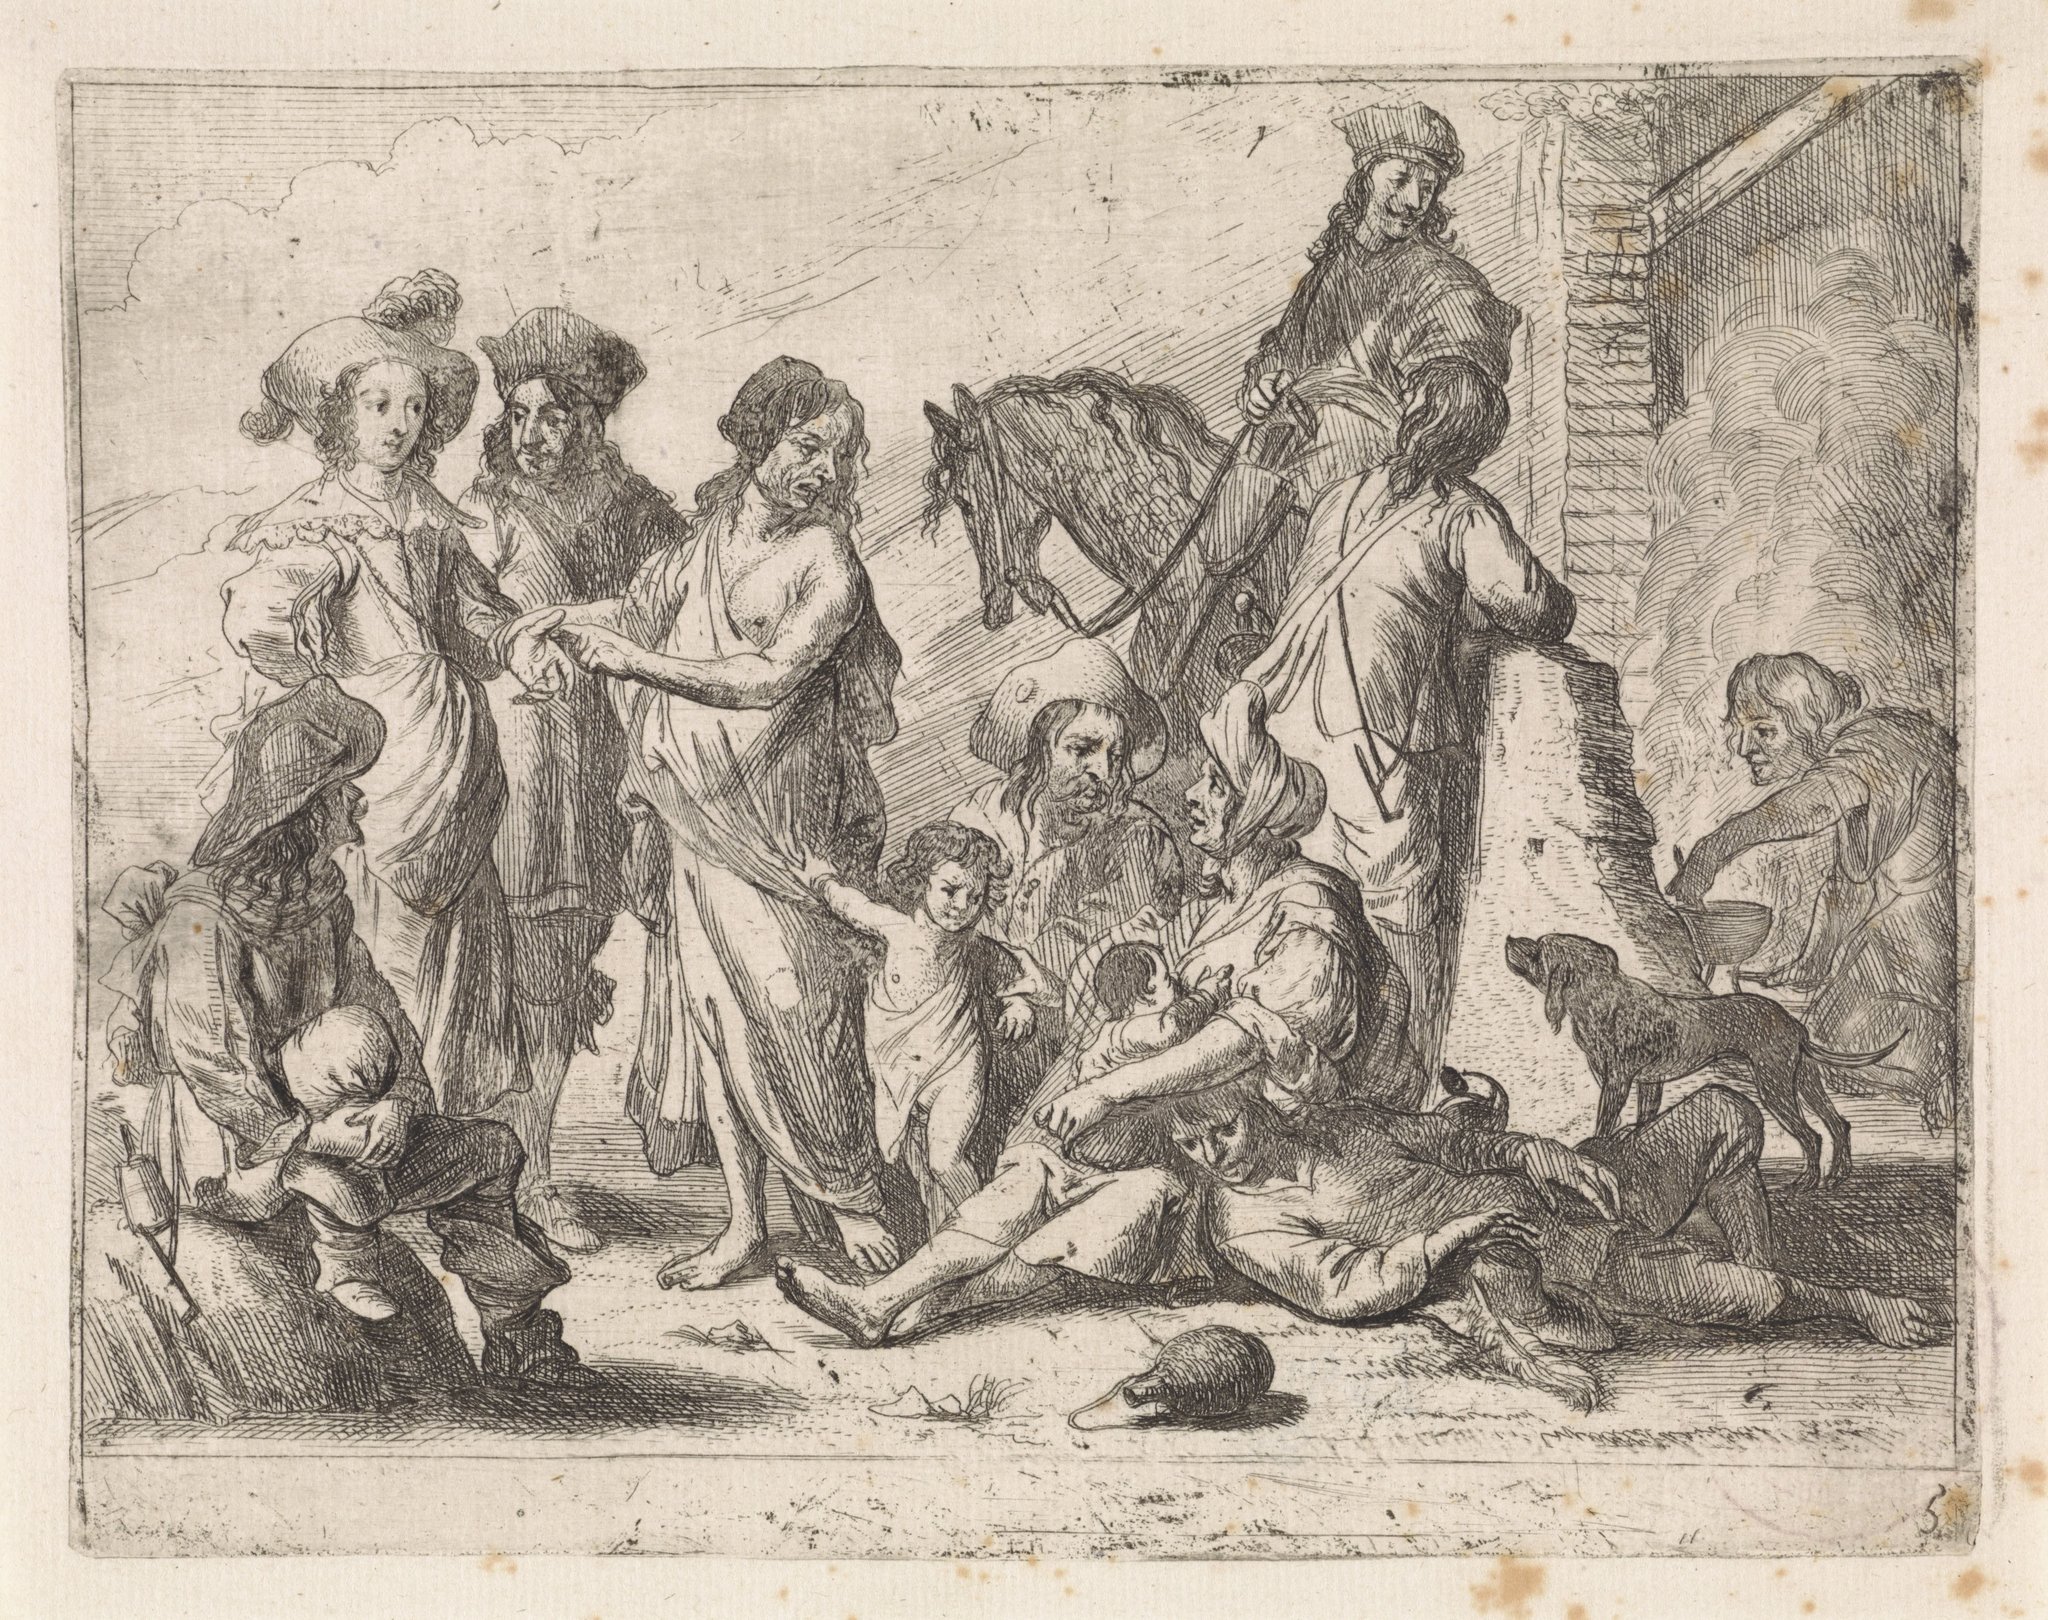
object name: print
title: Genretaferelen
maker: cornelis de wael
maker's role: draughtsman, print maker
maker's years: 1592-1667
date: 1630-1648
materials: paper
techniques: engraving, etching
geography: italy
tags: nursing, suckling, contrast between rich and poor, fortune-teller ~ pleasure fair and circus, kitchen-utensils: pot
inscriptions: collector's mark: Lugt 240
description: Te midden van boeren leest een in lompen gehulde waarzegster de hand van een rijkgeklede vrouw. De waarzegster kijkt om naar een boerin die haar kind de borst geeft. Rechts bij een muur roert een vrouw in een kookpot.